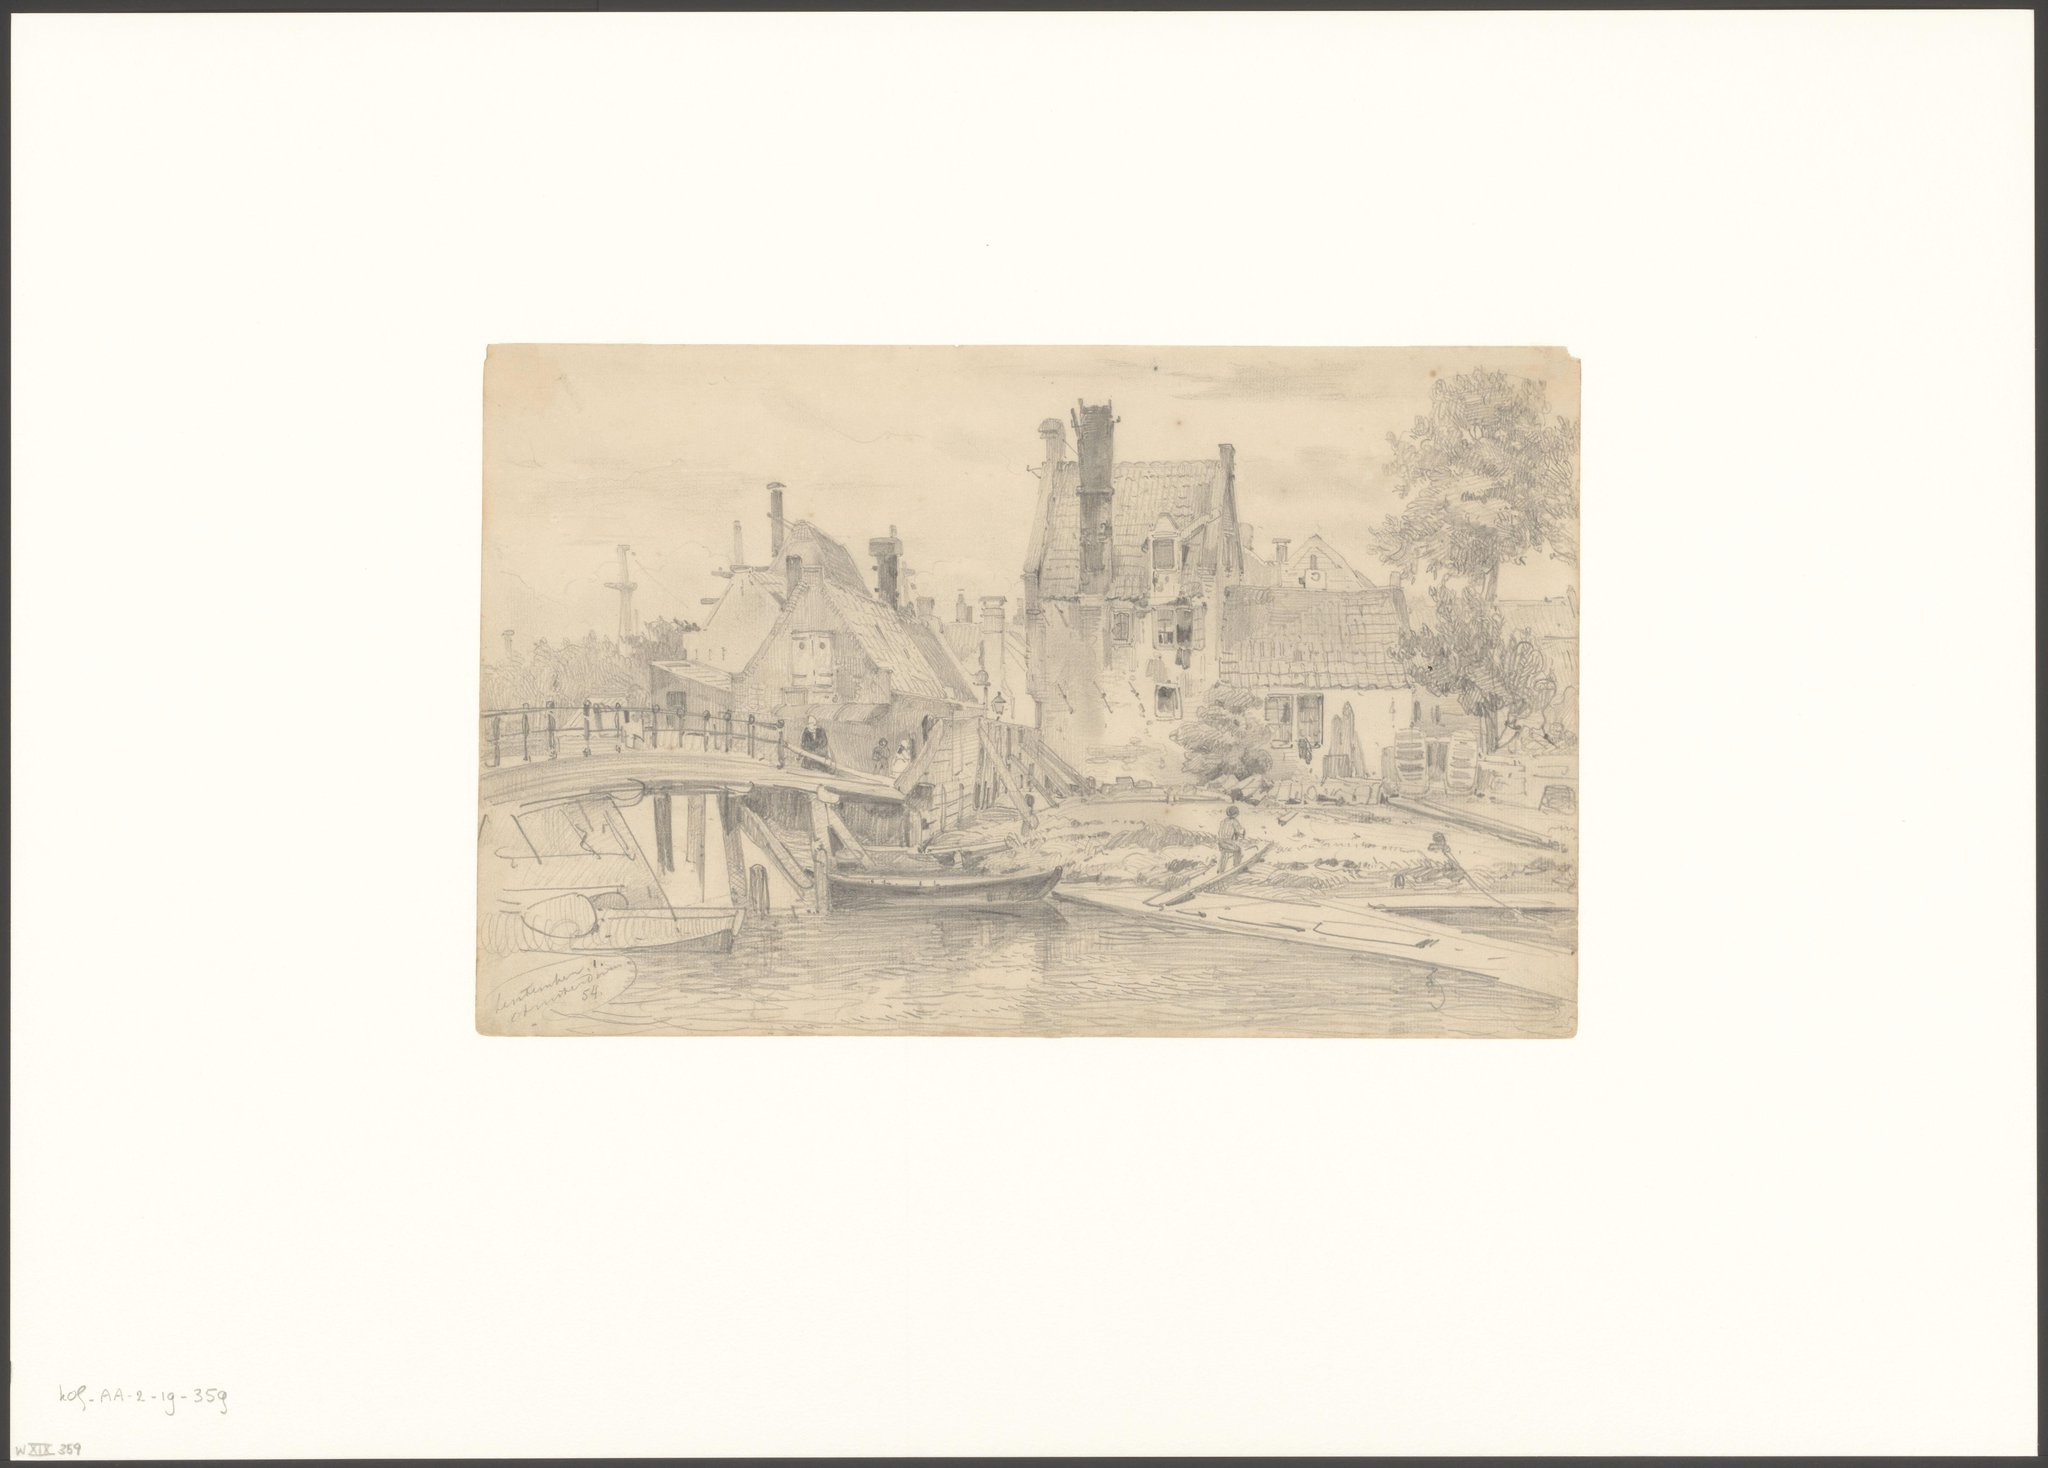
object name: drawing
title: Gezicht op de Zoutkeetsgracht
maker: willem anthonie van deventer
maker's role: draughtsman, painter, print maker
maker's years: 1824-1893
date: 1854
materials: paper, pencil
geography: amsterdam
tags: city-view in general; 'veduta', canal, bridge in city across river, canal, etc.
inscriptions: inscription: ‘W. Ant van Deventer / Vierwindenstraat bij de K[...]oomsbrug-’, date: ‘[...]nt[...] / Amsterdam / 54.’, collector's mark: Lugt 800a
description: Tekening binnen de Atlas Van Eck ingedeeld op wijknummer 19.